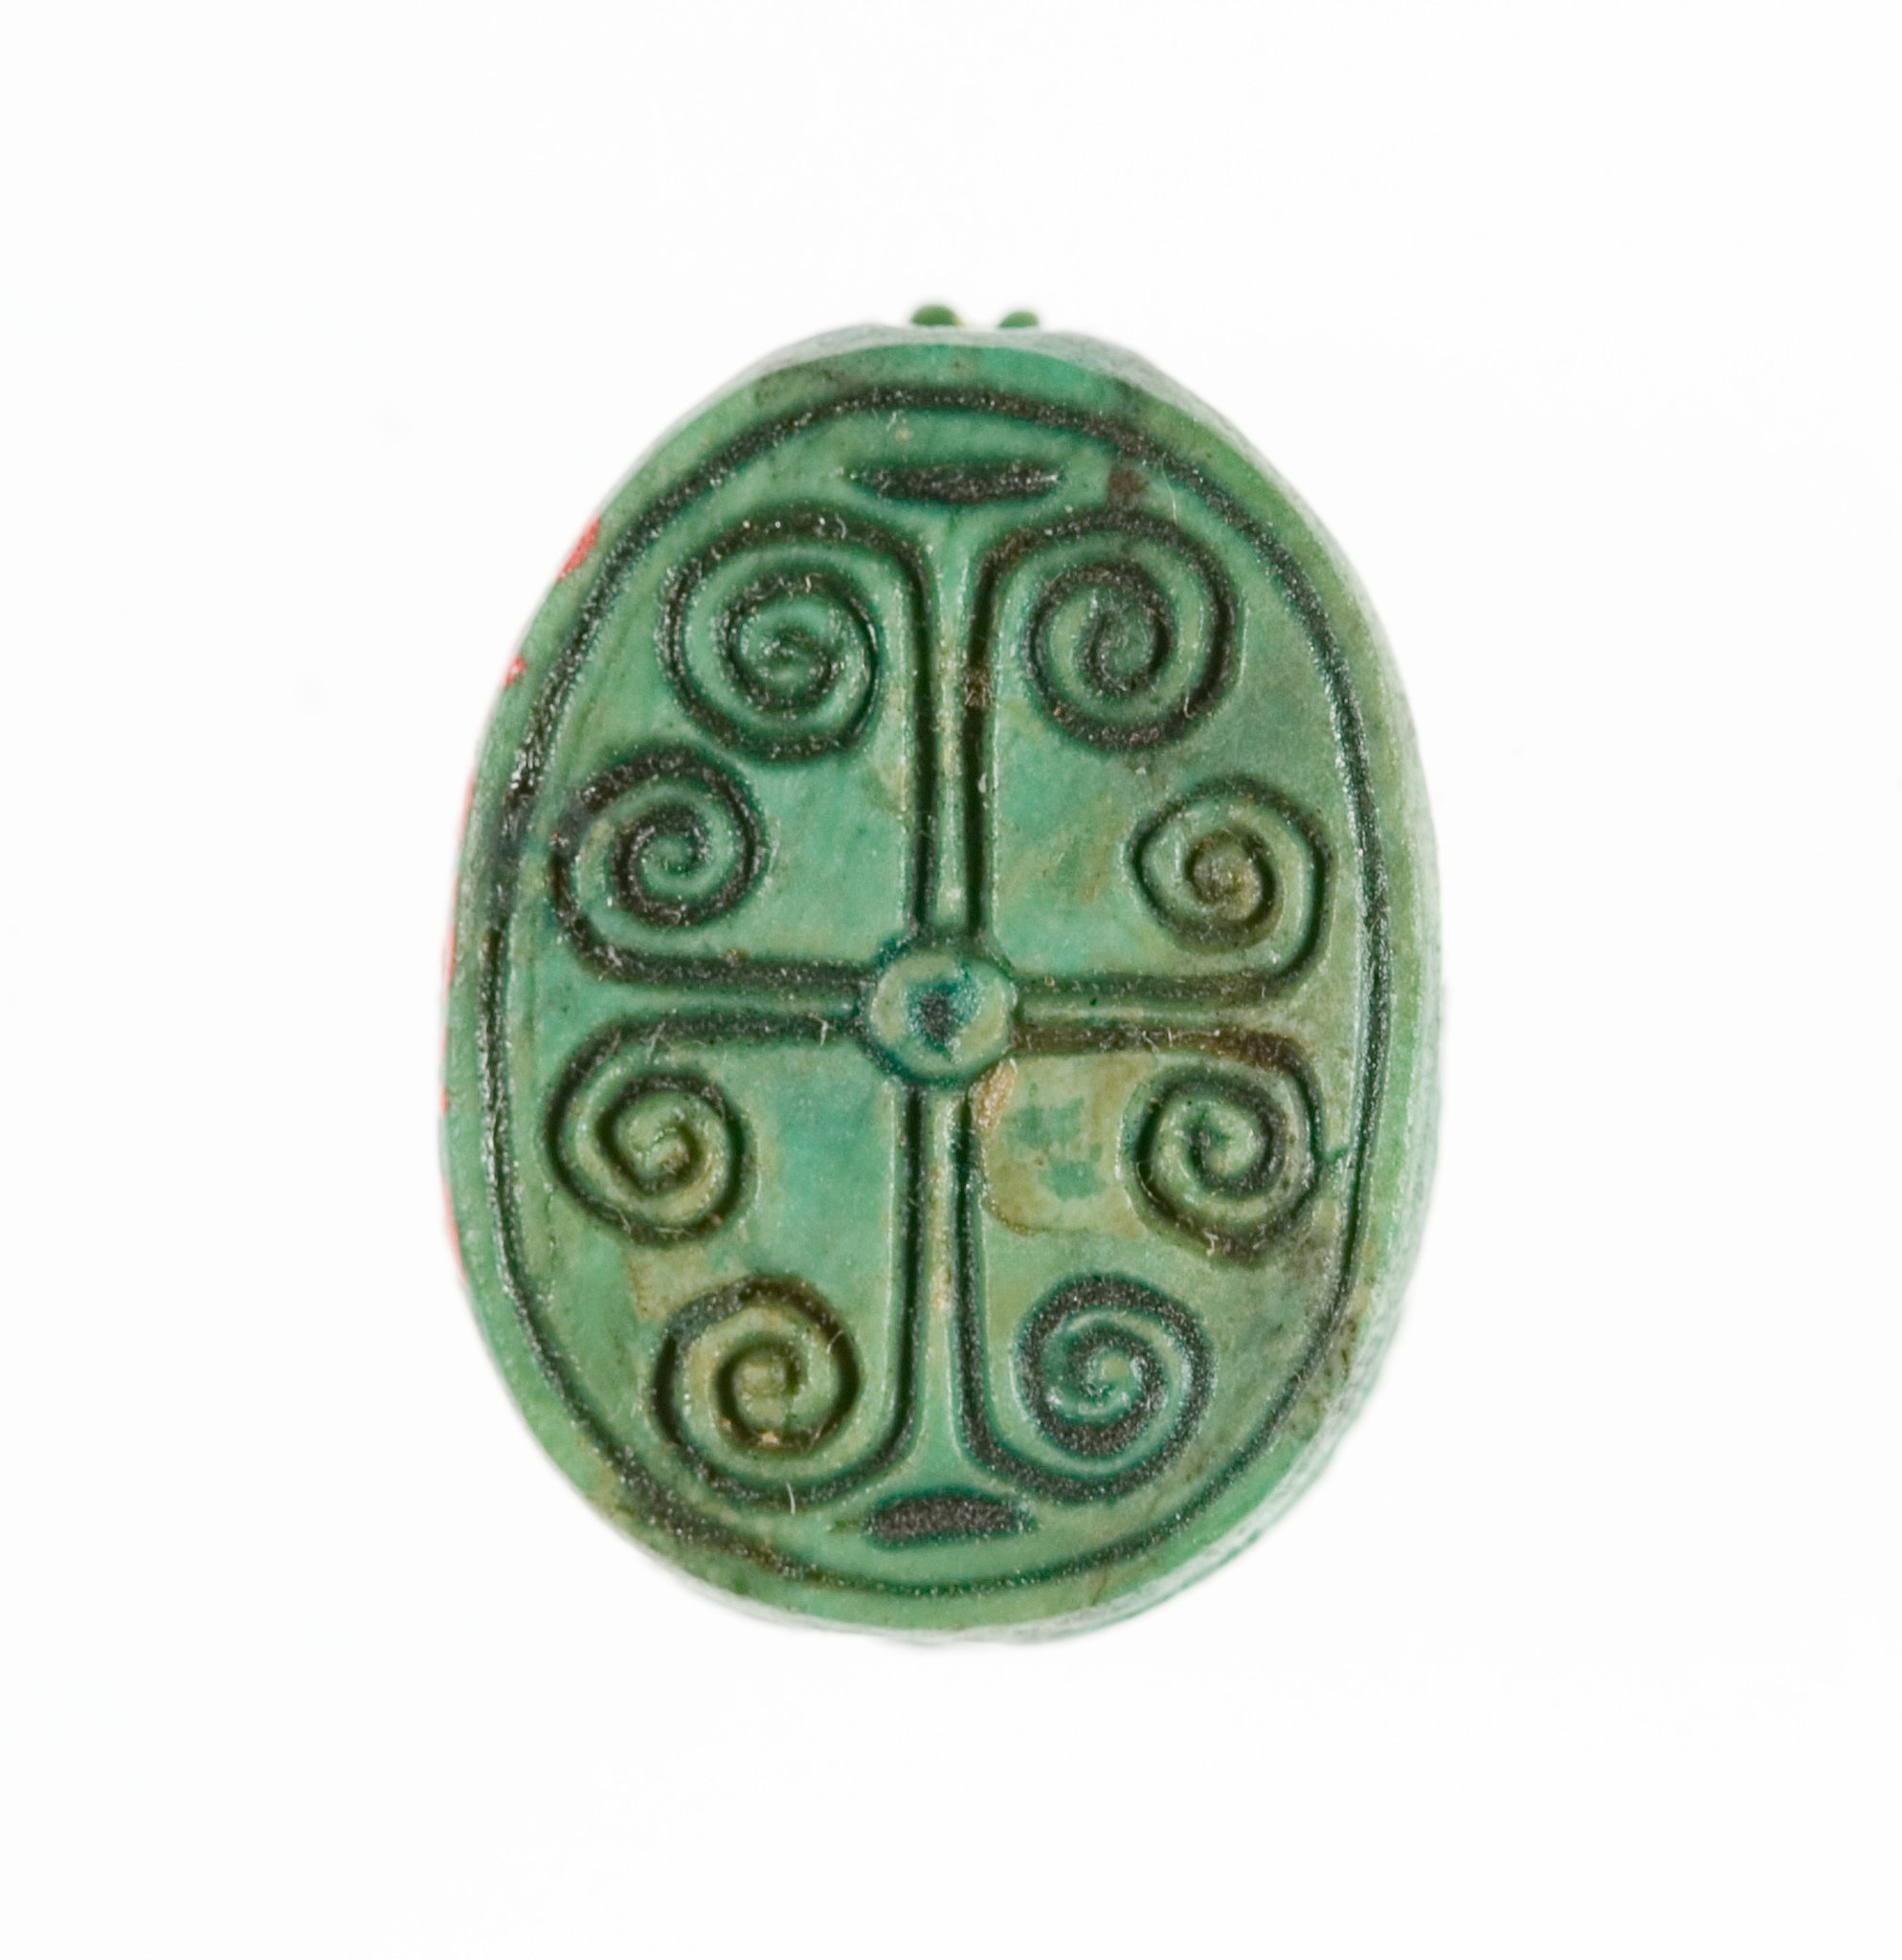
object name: scarab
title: Scarab Inscribed with a Geometric Pattern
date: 1479-1458 BCE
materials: stone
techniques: glazing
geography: egypt